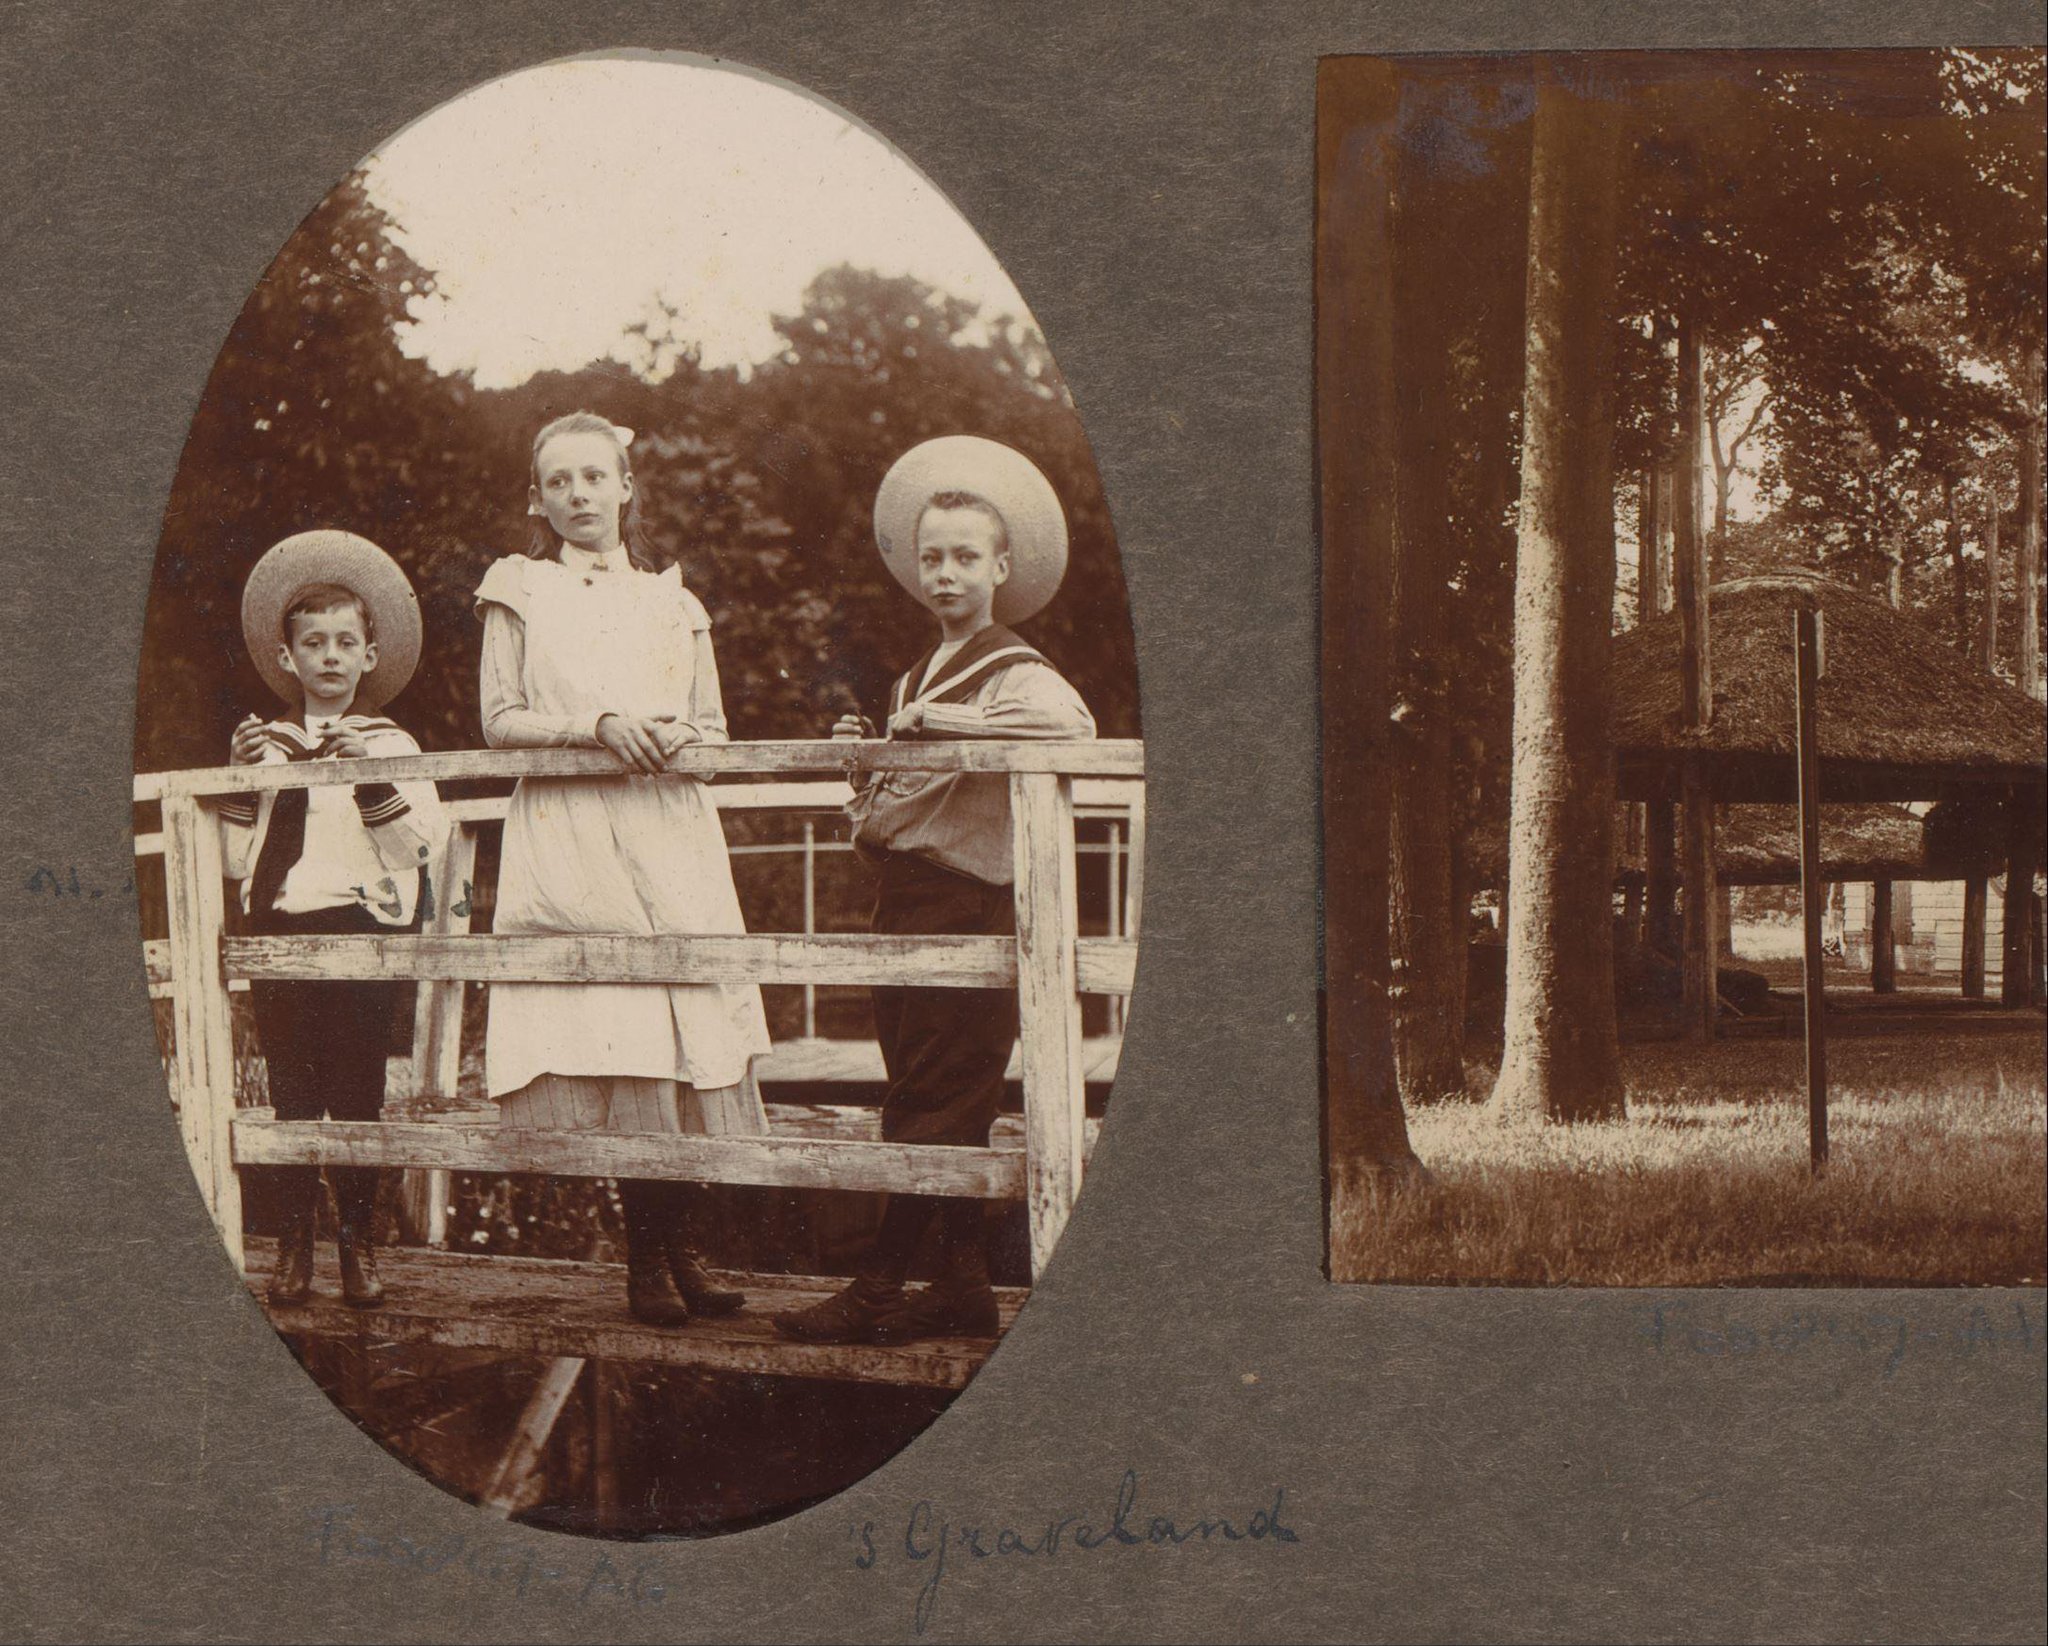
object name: album leaf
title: Groepsportret van een meisje met jurk en twee jongens in matrozenpak in 's-Graveland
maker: Anonymous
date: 1902-1906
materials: cardboard, paper, photographic support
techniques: gelatin silver print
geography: s-graveland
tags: child, dress, gown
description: Onderdeel van Reisalbum van een Nederlandse familie met bezienswaardigheden in Europa, Egypte en New York.